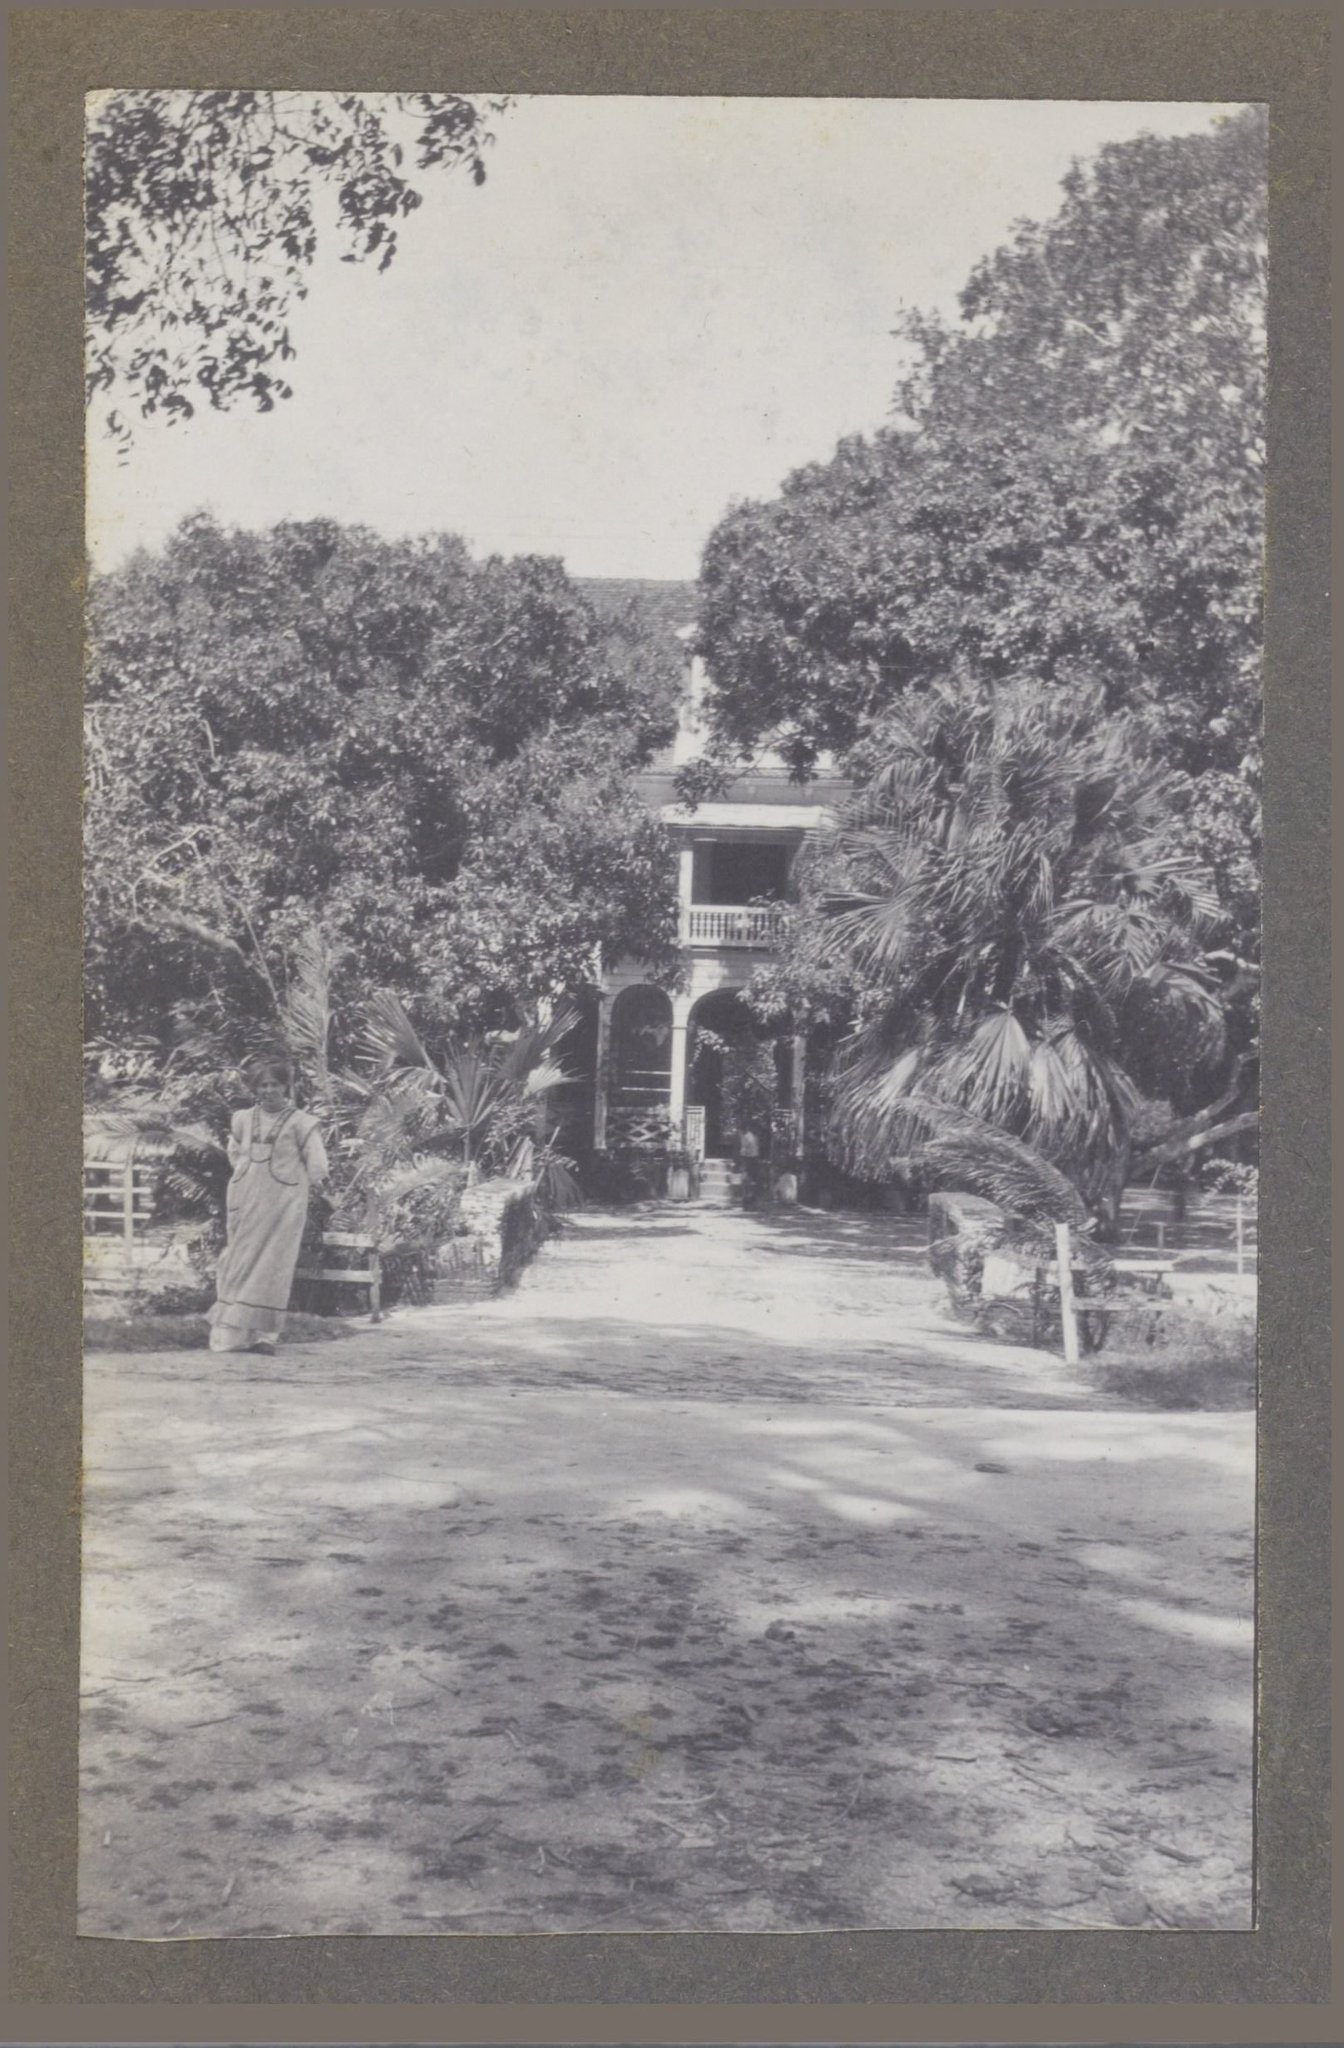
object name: photograph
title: Vrouw staande voor huis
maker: Anonymous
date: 1912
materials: photographic support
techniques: photography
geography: suriname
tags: country-house, suriname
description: Een vrouw staande voor een groot huis tussen bomen. Onderdeel van het fotoalbum over het leven van de familie Gonggrijp in Suriname rond 1912.